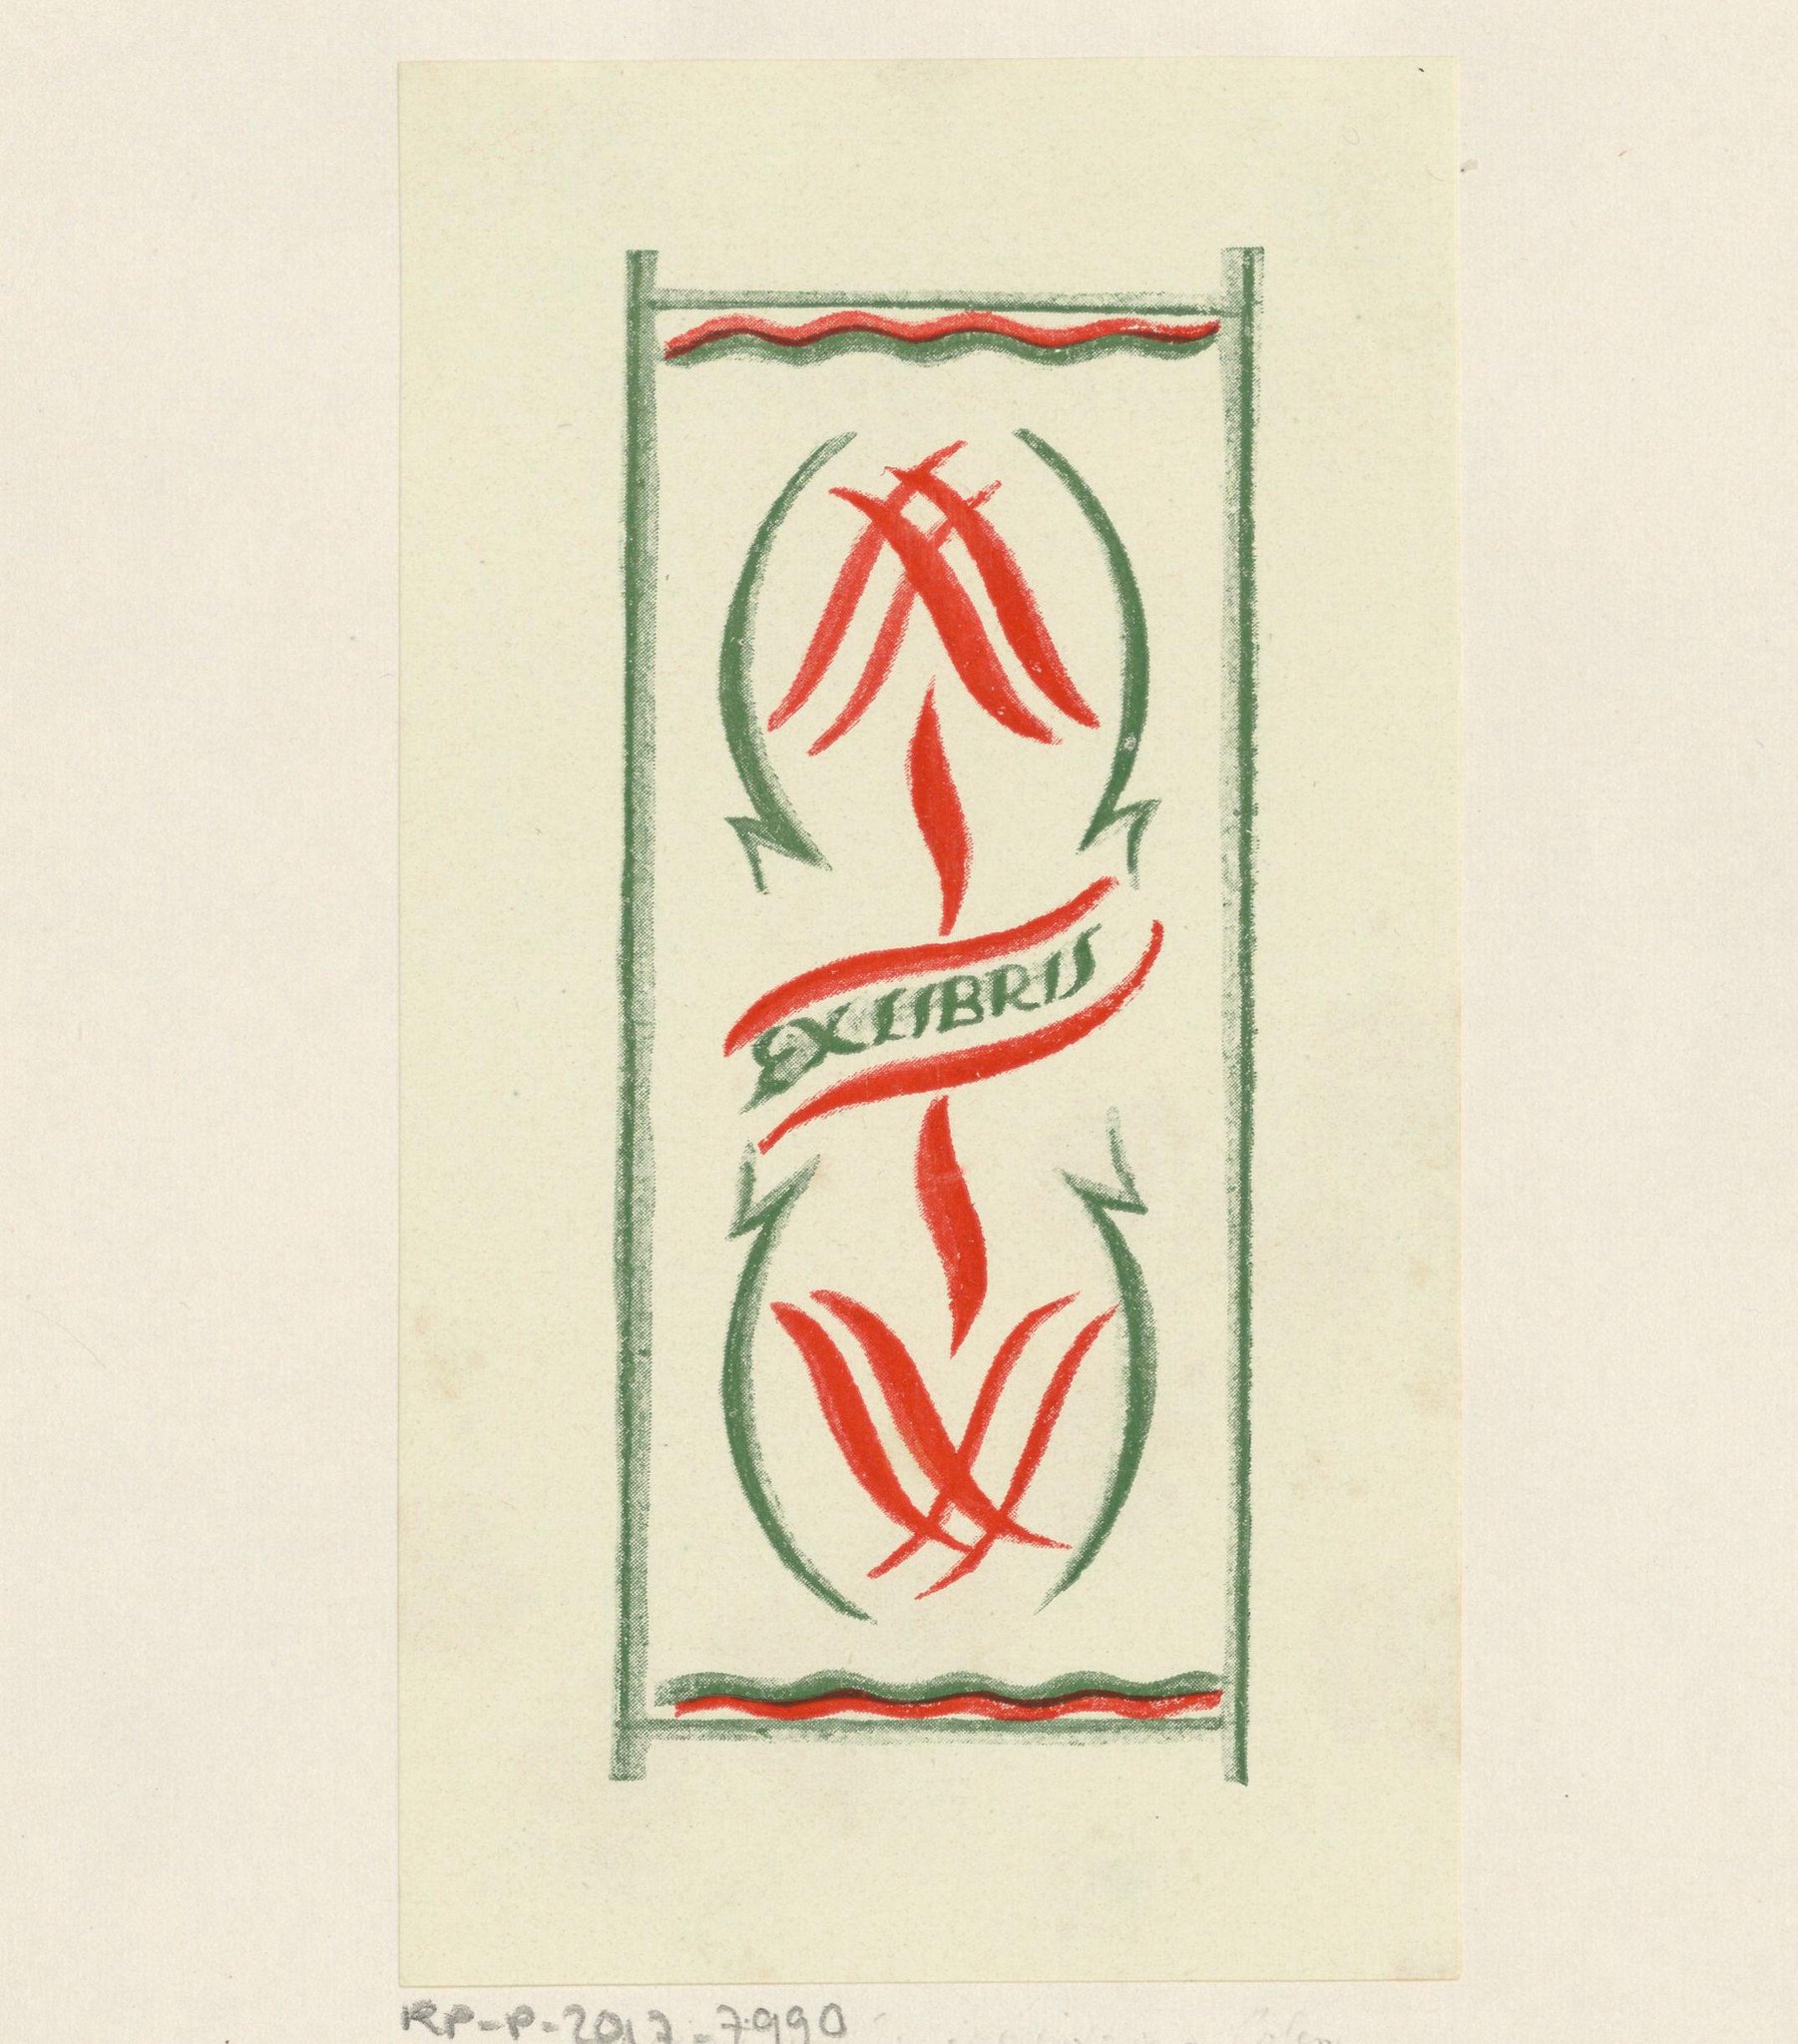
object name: photomechanical print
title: Ex libris van onbekend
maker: Anonymous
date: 1900-1999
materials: paper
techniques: autotype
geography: poland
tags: abstract ideas and concepts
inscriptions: inscription: ‘Kazimiera/ Zawistowitiska [?]/ Polonia’